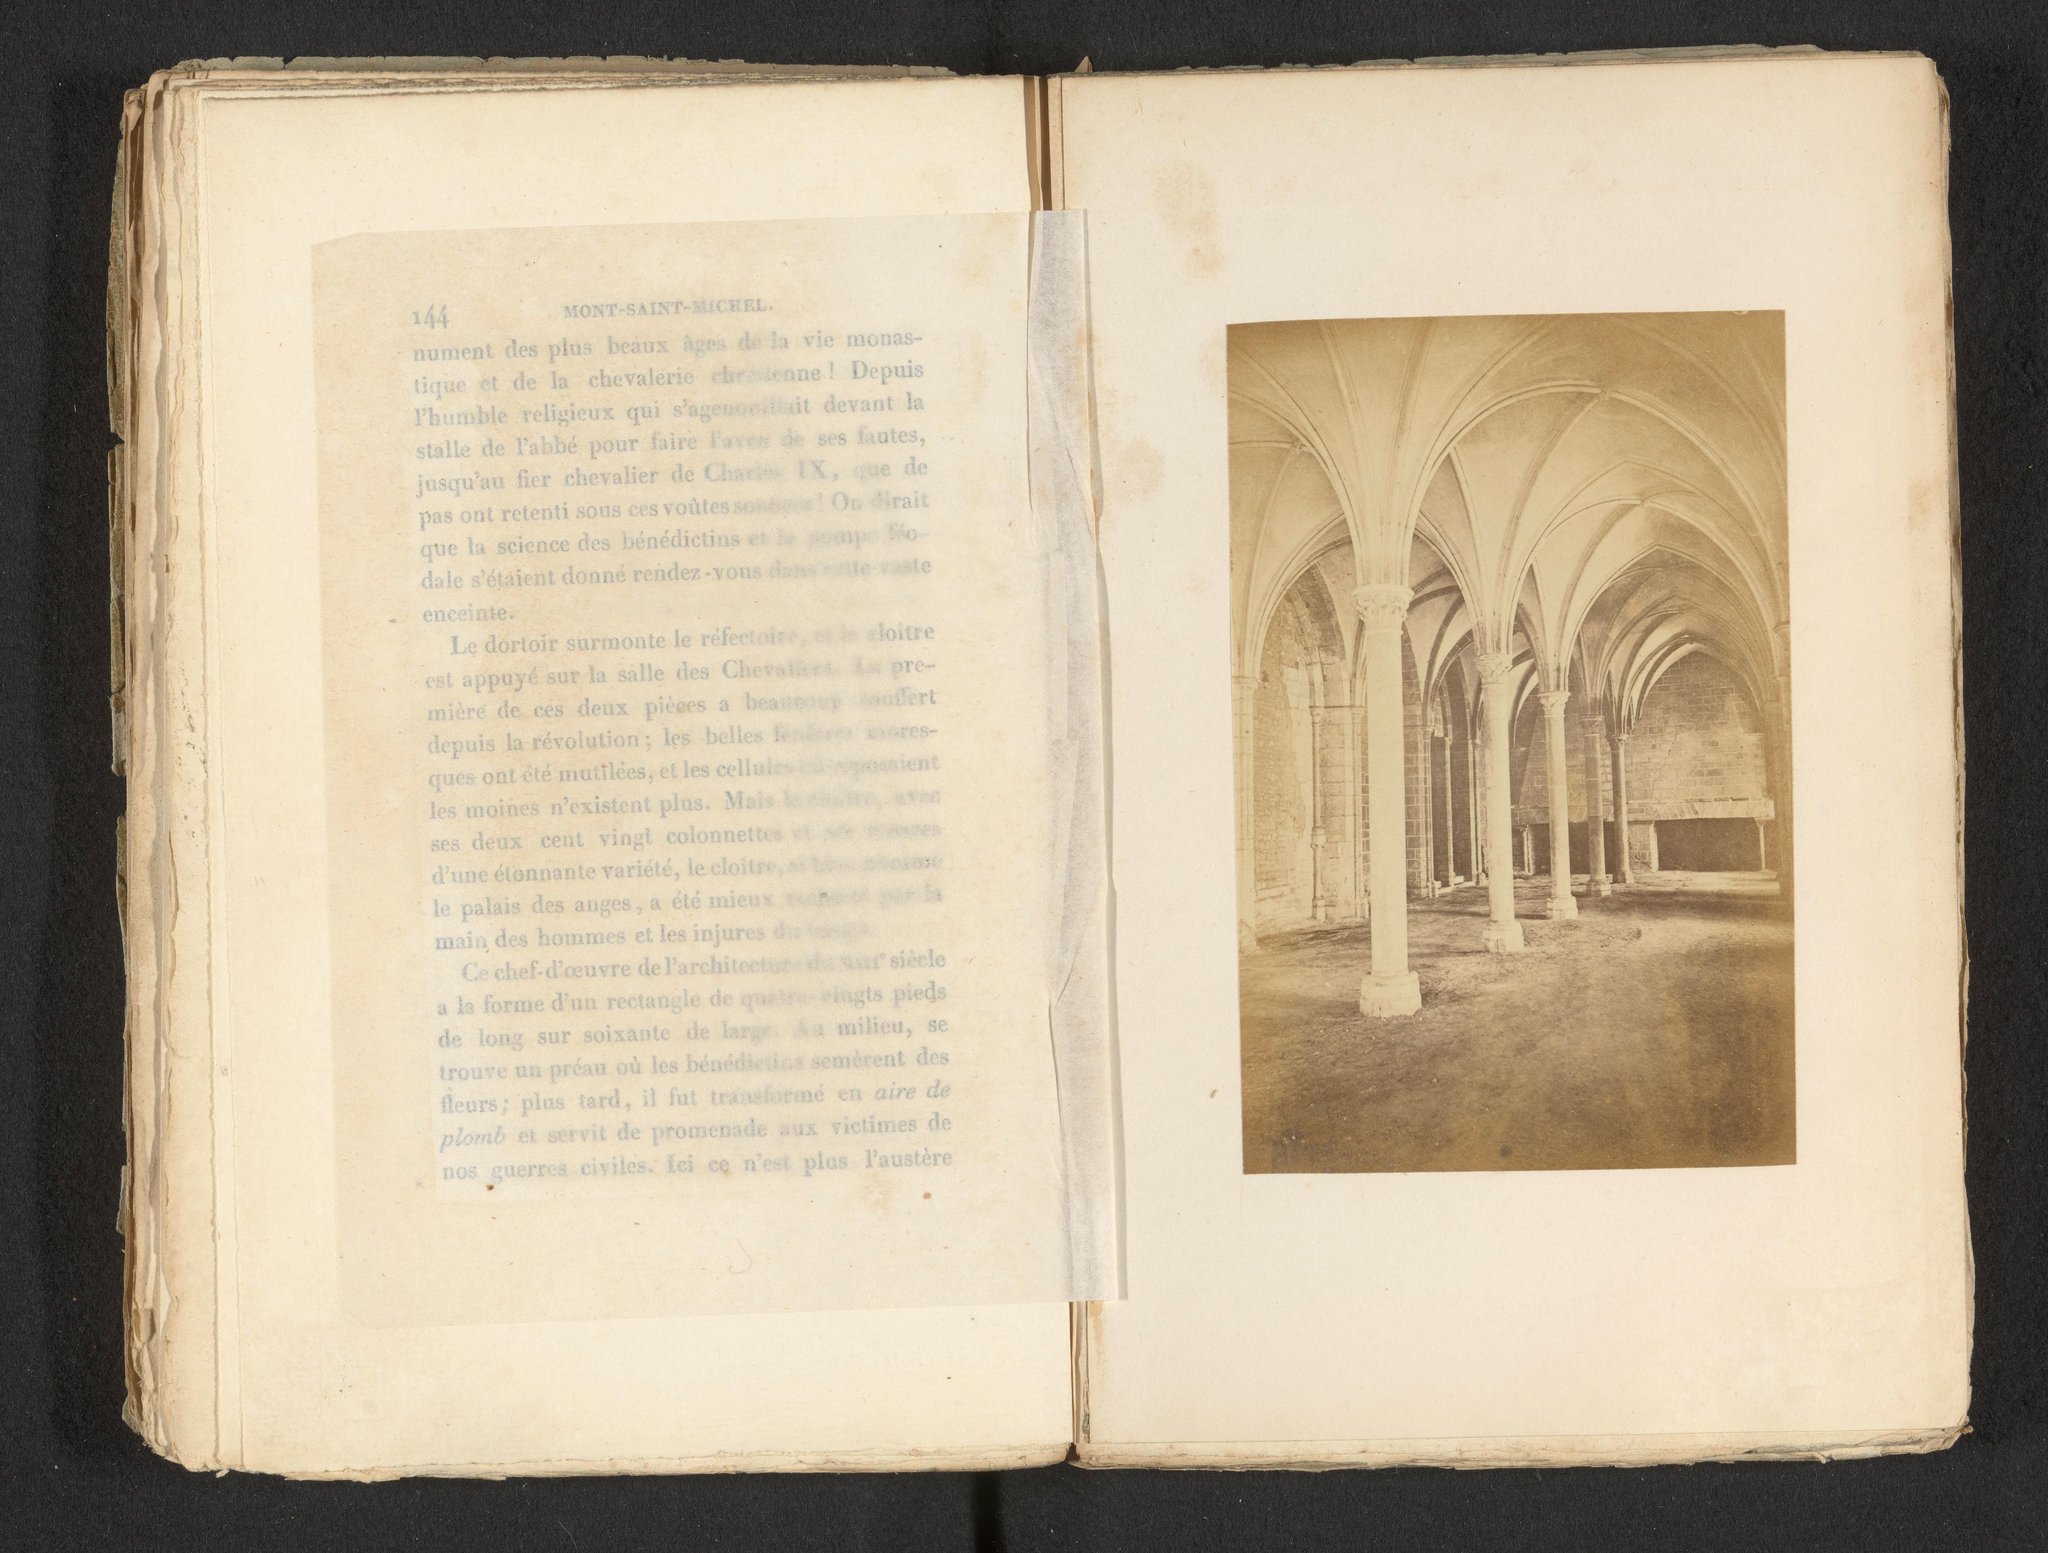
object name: page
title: Zuilenrij in het klooster van Mont Saint-Michel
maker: Anonymous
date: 1866-1876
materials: photographic support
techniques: albumen print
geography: mont saint-michel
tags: abbey, monastery, convent ~ roman catholic church, interior ~ representation of a building, arcade ~ architecture